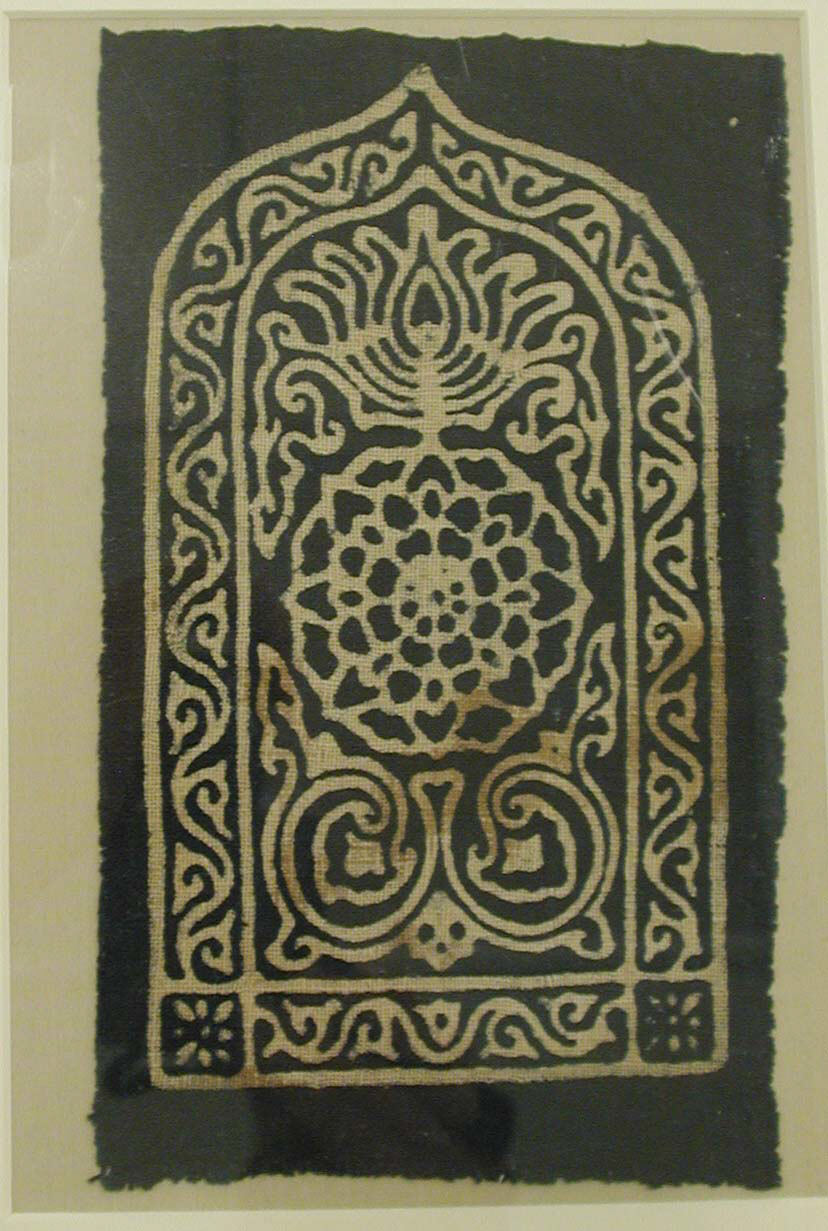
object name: textile fragment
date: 1401-1600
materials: cotton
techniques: dyeing, weave, resist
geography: india